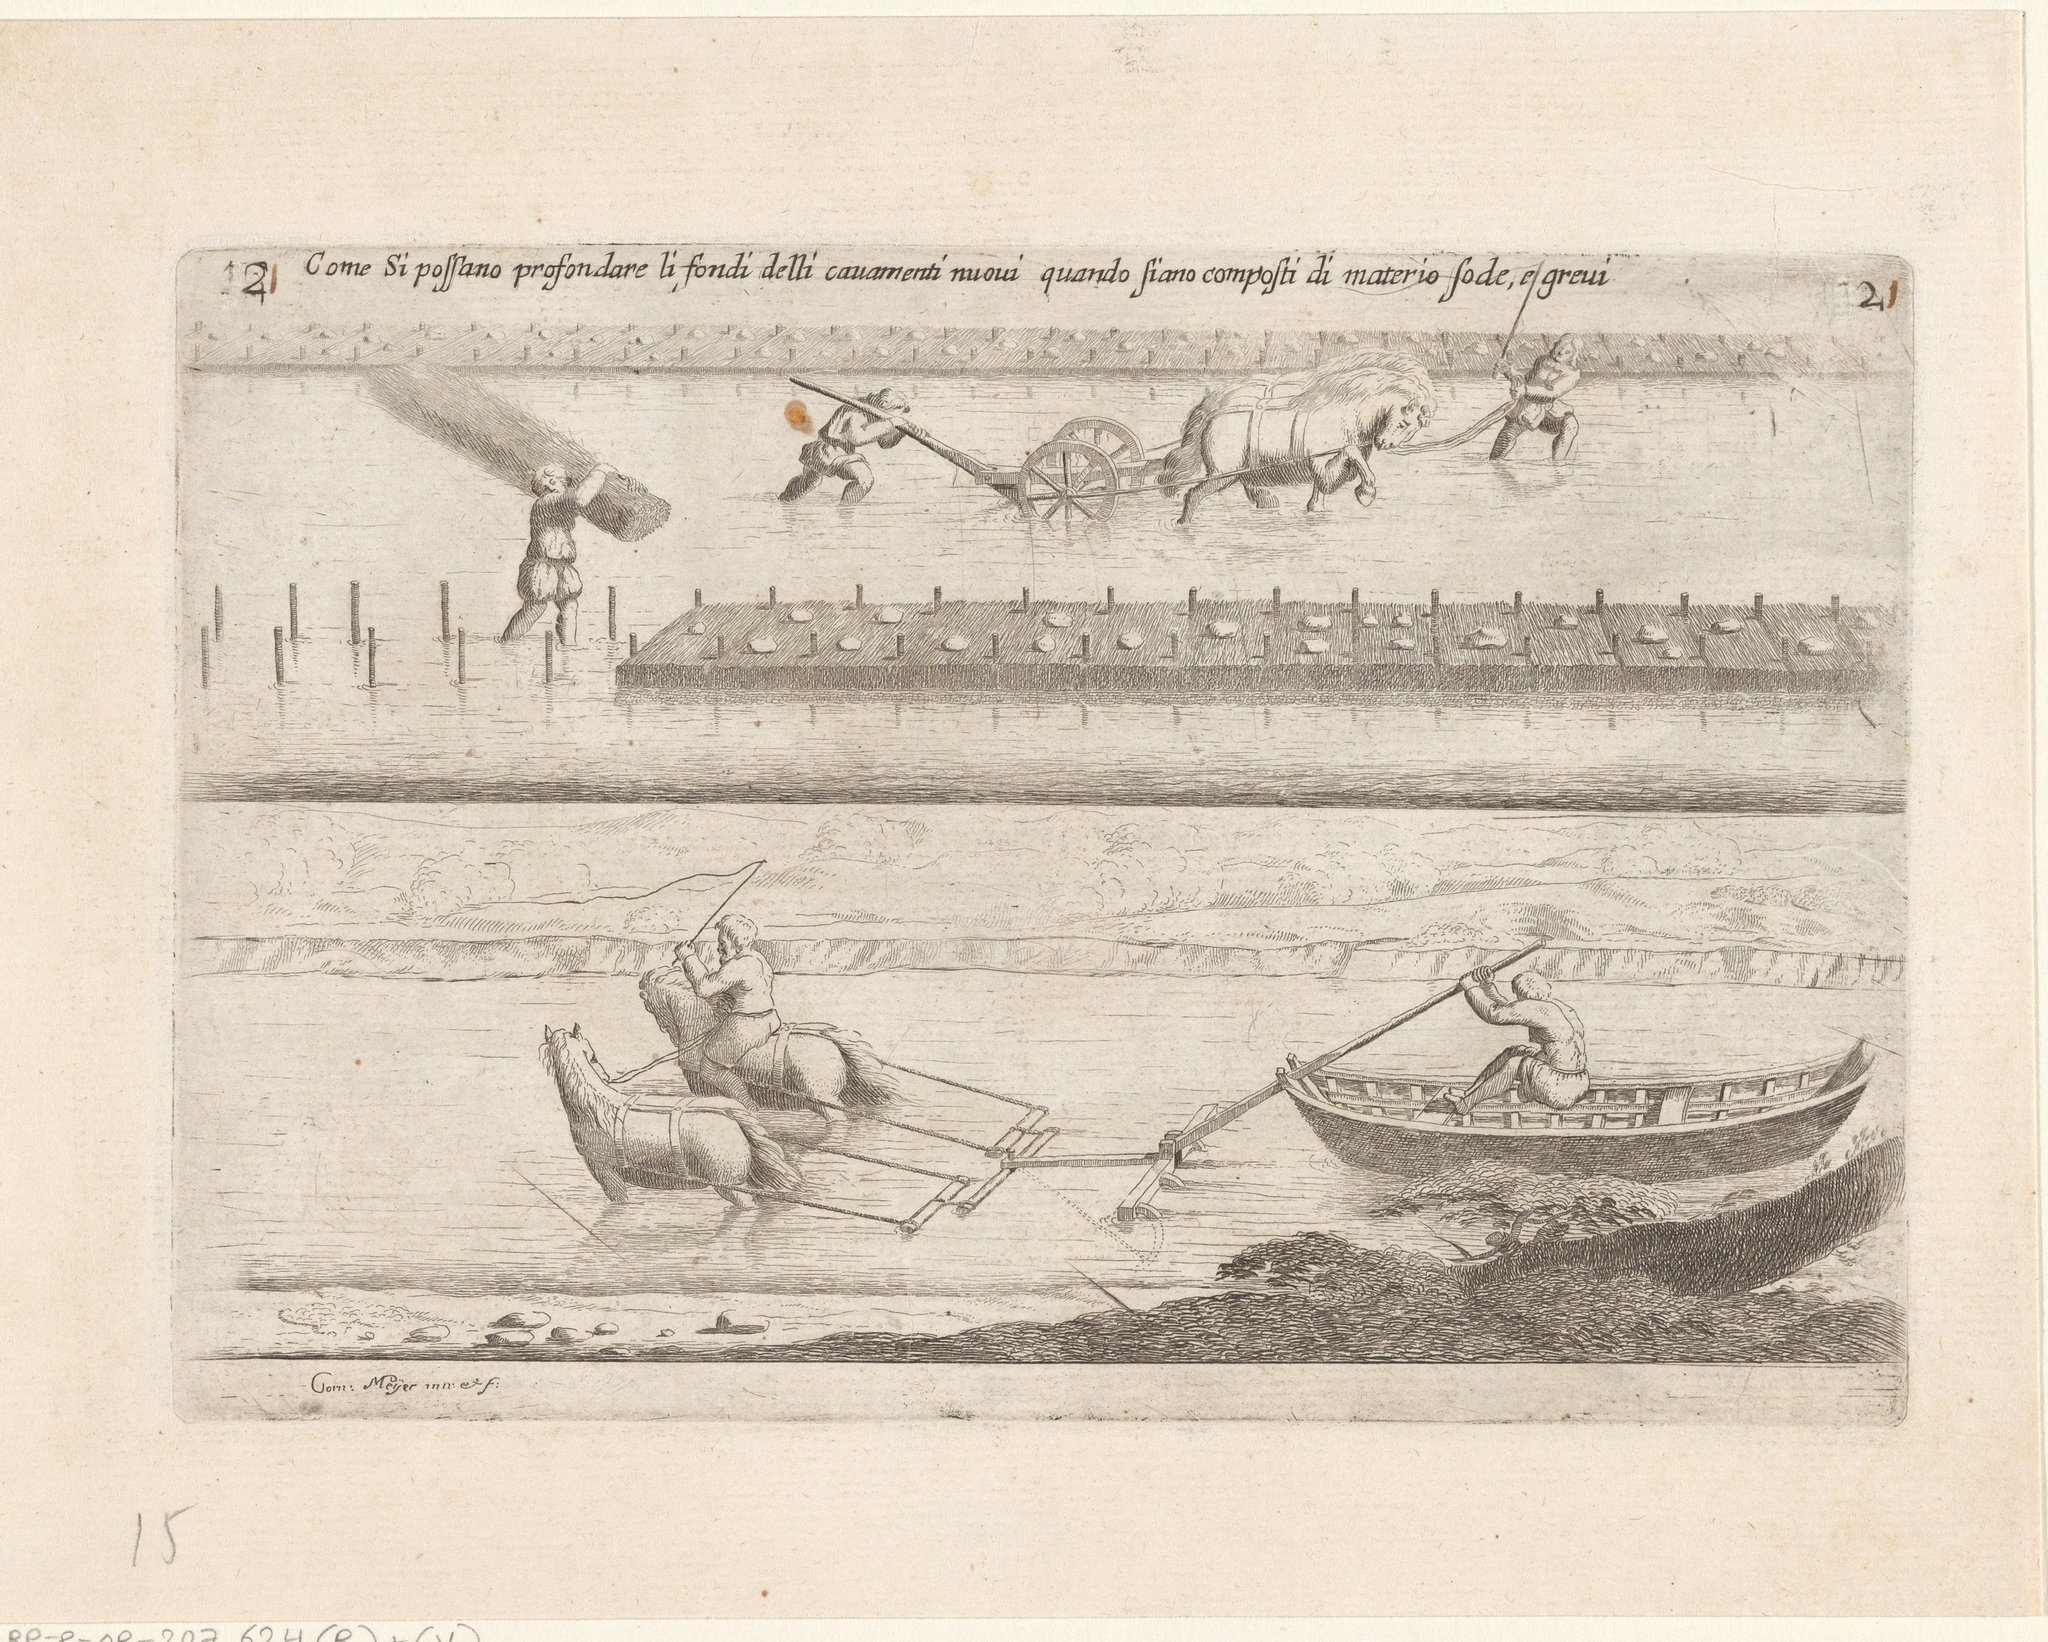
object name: print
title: Het leggen van fundering in de rivier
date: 1677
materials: paper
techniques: etching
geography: rome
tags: river, dredge, dredging machine, laying the foundations; trench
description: Deze prent maakte oorspronkelijk deel uit van een publicatie bestaande uit drie delen, uitgegeven door G.G. Komarek in Rome in 1696. Het eerste deel zit achter een titelpagina met de titel: L'arte di rendere i fiumi navigabili, in varij modi, con altre nuove inventioni, e varij altri segreti. Deel twee zit achter een titelpagina met de titel: Racolta di varii segreti come si vedono nelle segventi figure. Deel drie zit achter een titelpagina met de titel: Osservazioni delle comete che dovranno seguire, e dell'ecclisse del primo satellite di Giove, et altre propositioni prosicue da farsi per commodo & ornamento della città. Deze prent komt uit het eerste deel. Prenten in de publicatie zijn naar ontwerp van Cornelis Meijer gemaakt door verschillende prentmakers, onder wie G.B. Falda, G. van Wittel, Gomar Wouters, etc. Er is ook een eerdere versie bekend van deze publicatie, uitgegeven in Rome in 1683, met de titel: L'arte di restituire a Roma la tralasciata navigazione del suo Tevere.